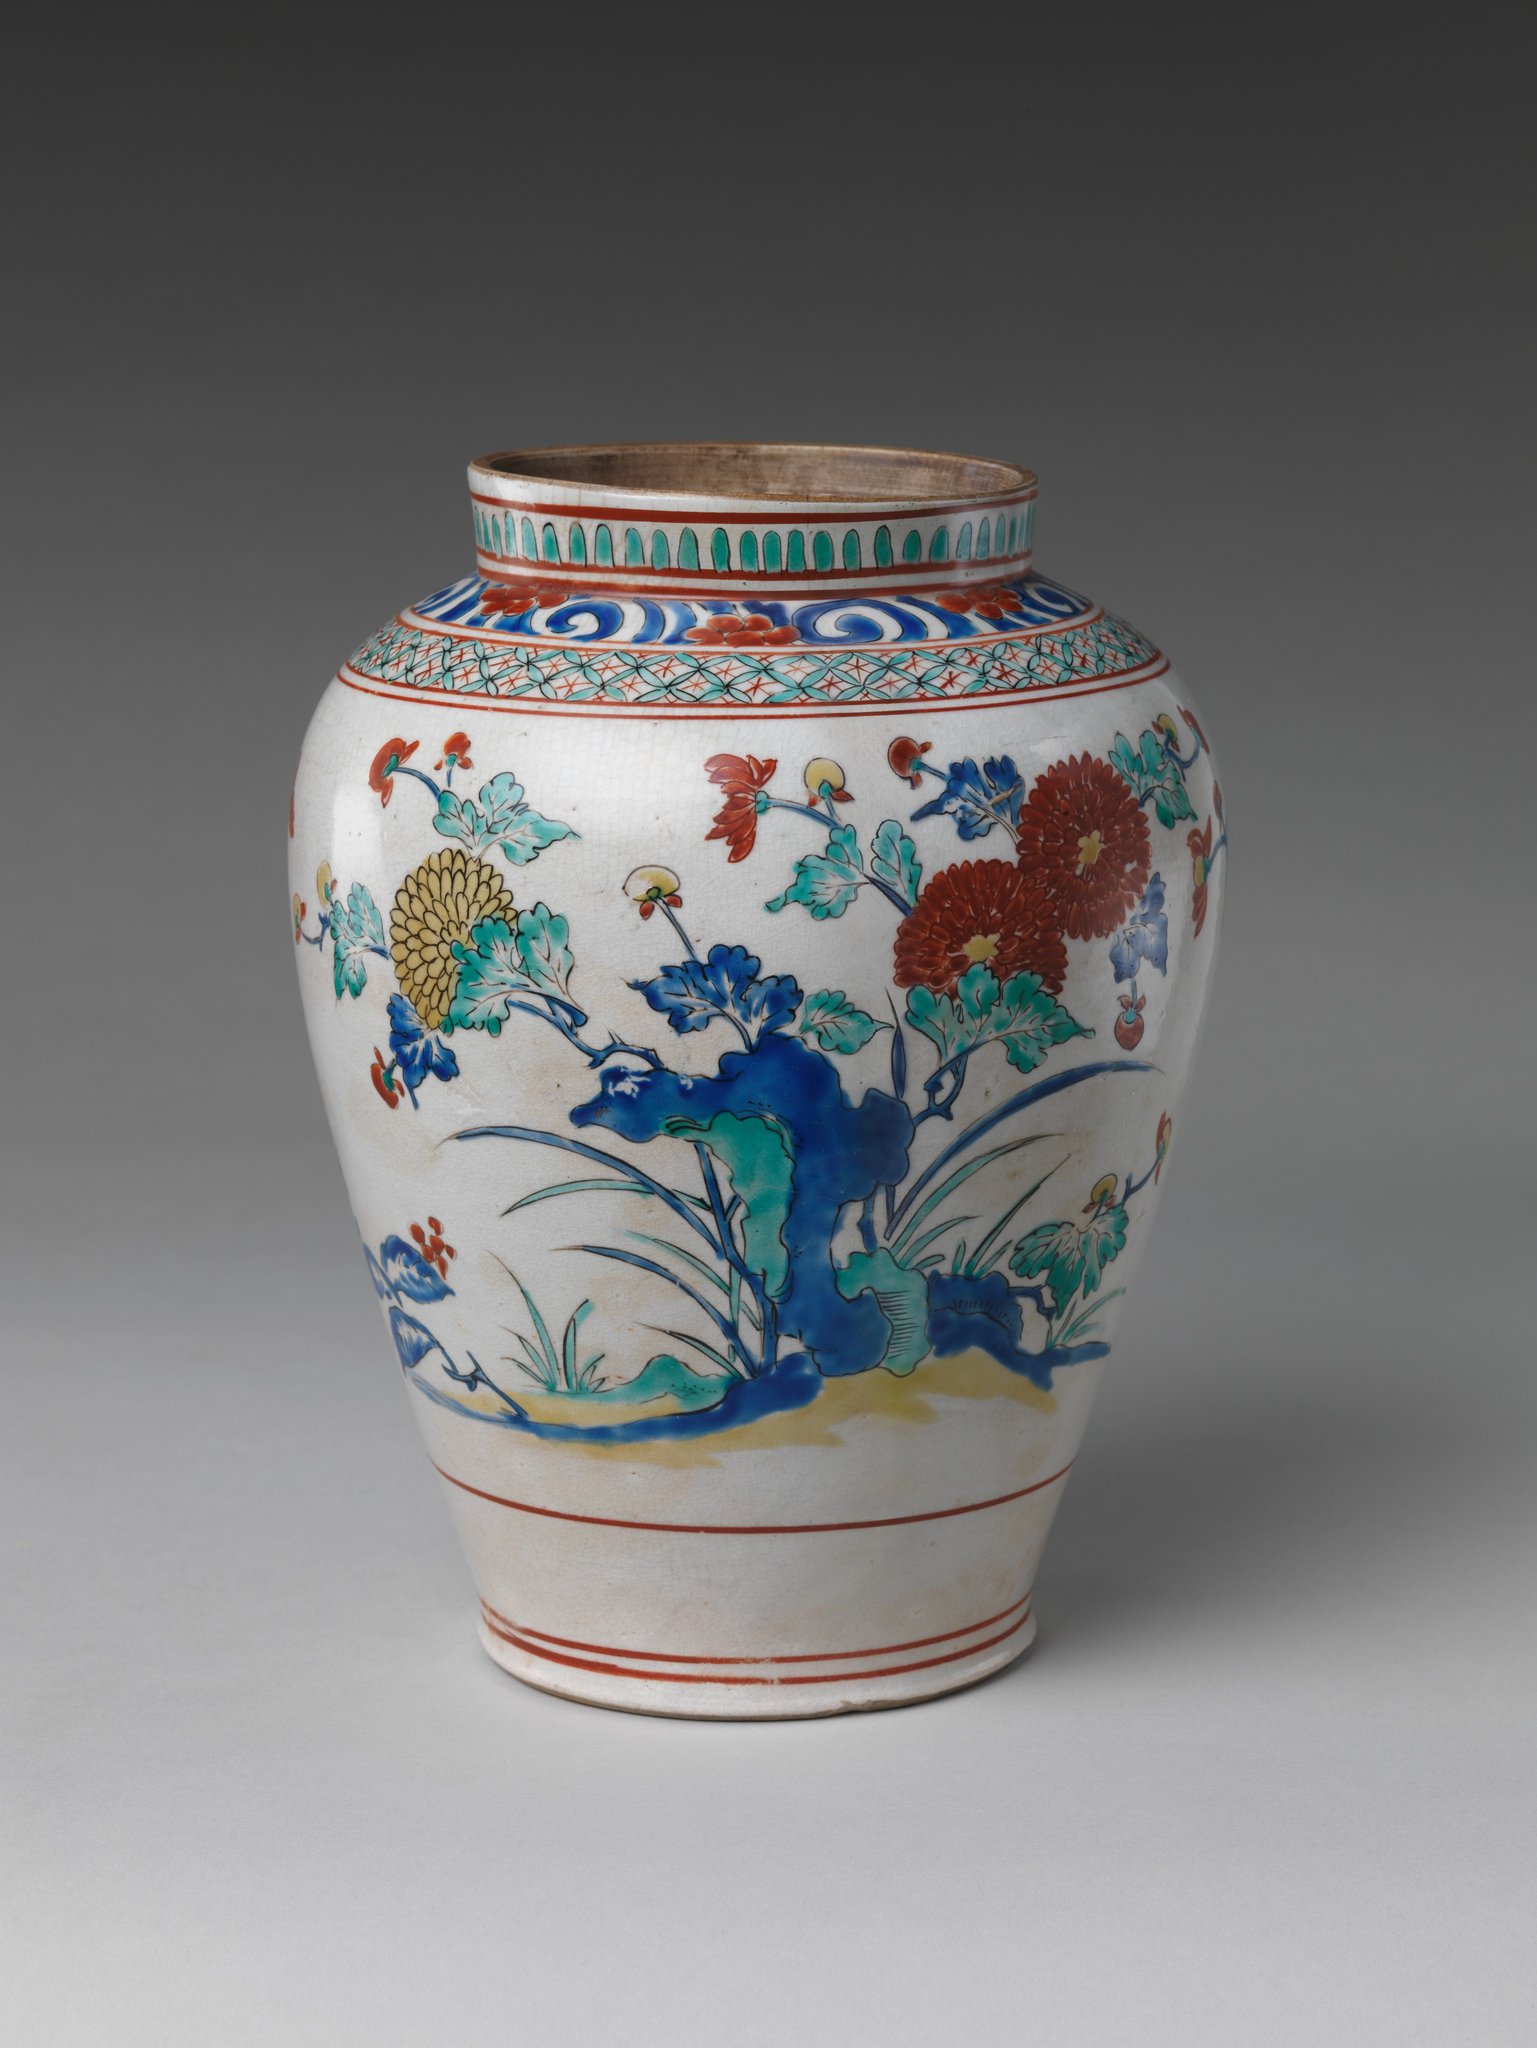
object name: jar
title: Jar with Chrysanthemums and Rocks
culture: japanese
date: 1701-1800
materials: enamel, glaze, porcelain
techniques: painting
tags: flowers